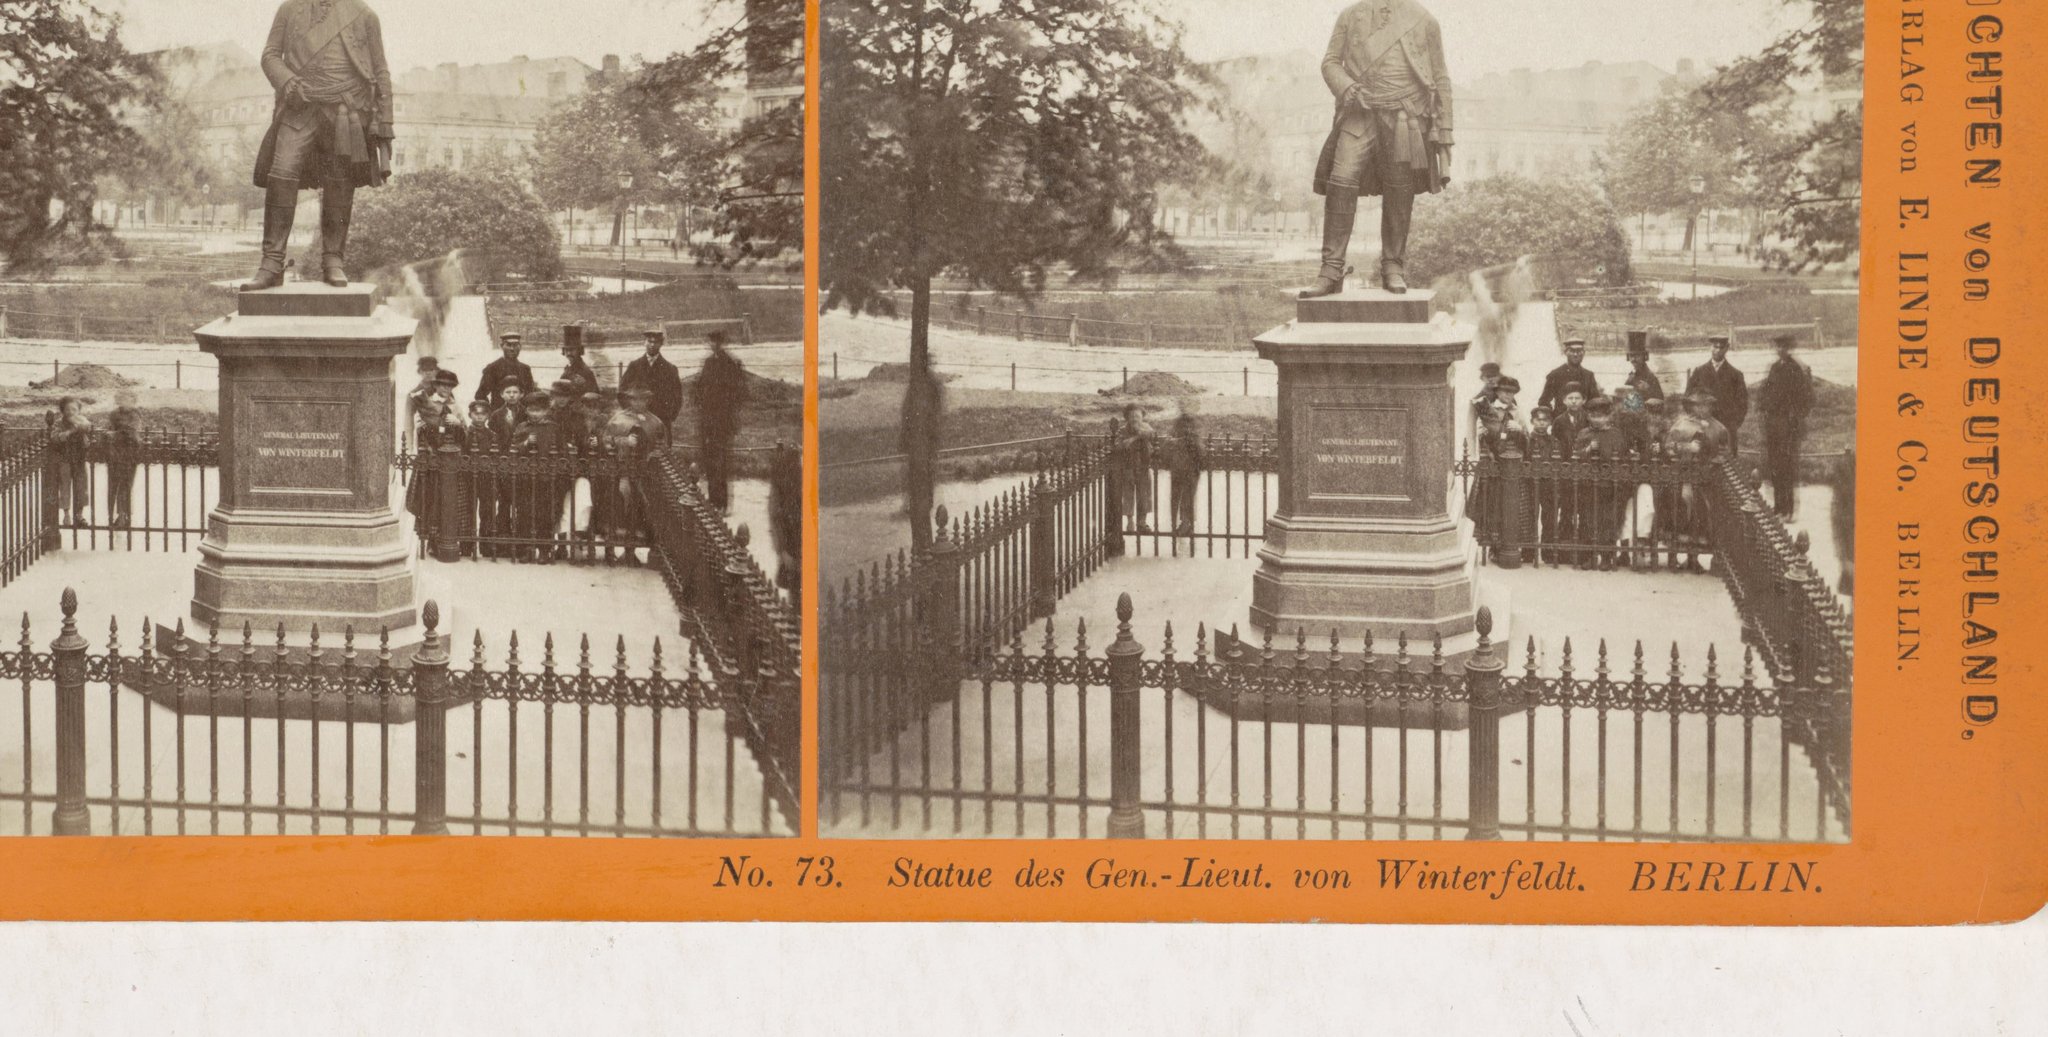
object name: stereograph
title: Standbeeld van generaal Hans Karl von Winterfeldt op het Wilhelmplatz, Berlijn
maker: johann friedrich stiehm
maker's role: fotograaf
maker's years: 1826-1902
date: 1868-1870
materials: cardboard, paper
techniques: albumen print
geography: berlin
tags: monument, statue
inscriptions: number: ‘No. 73.’